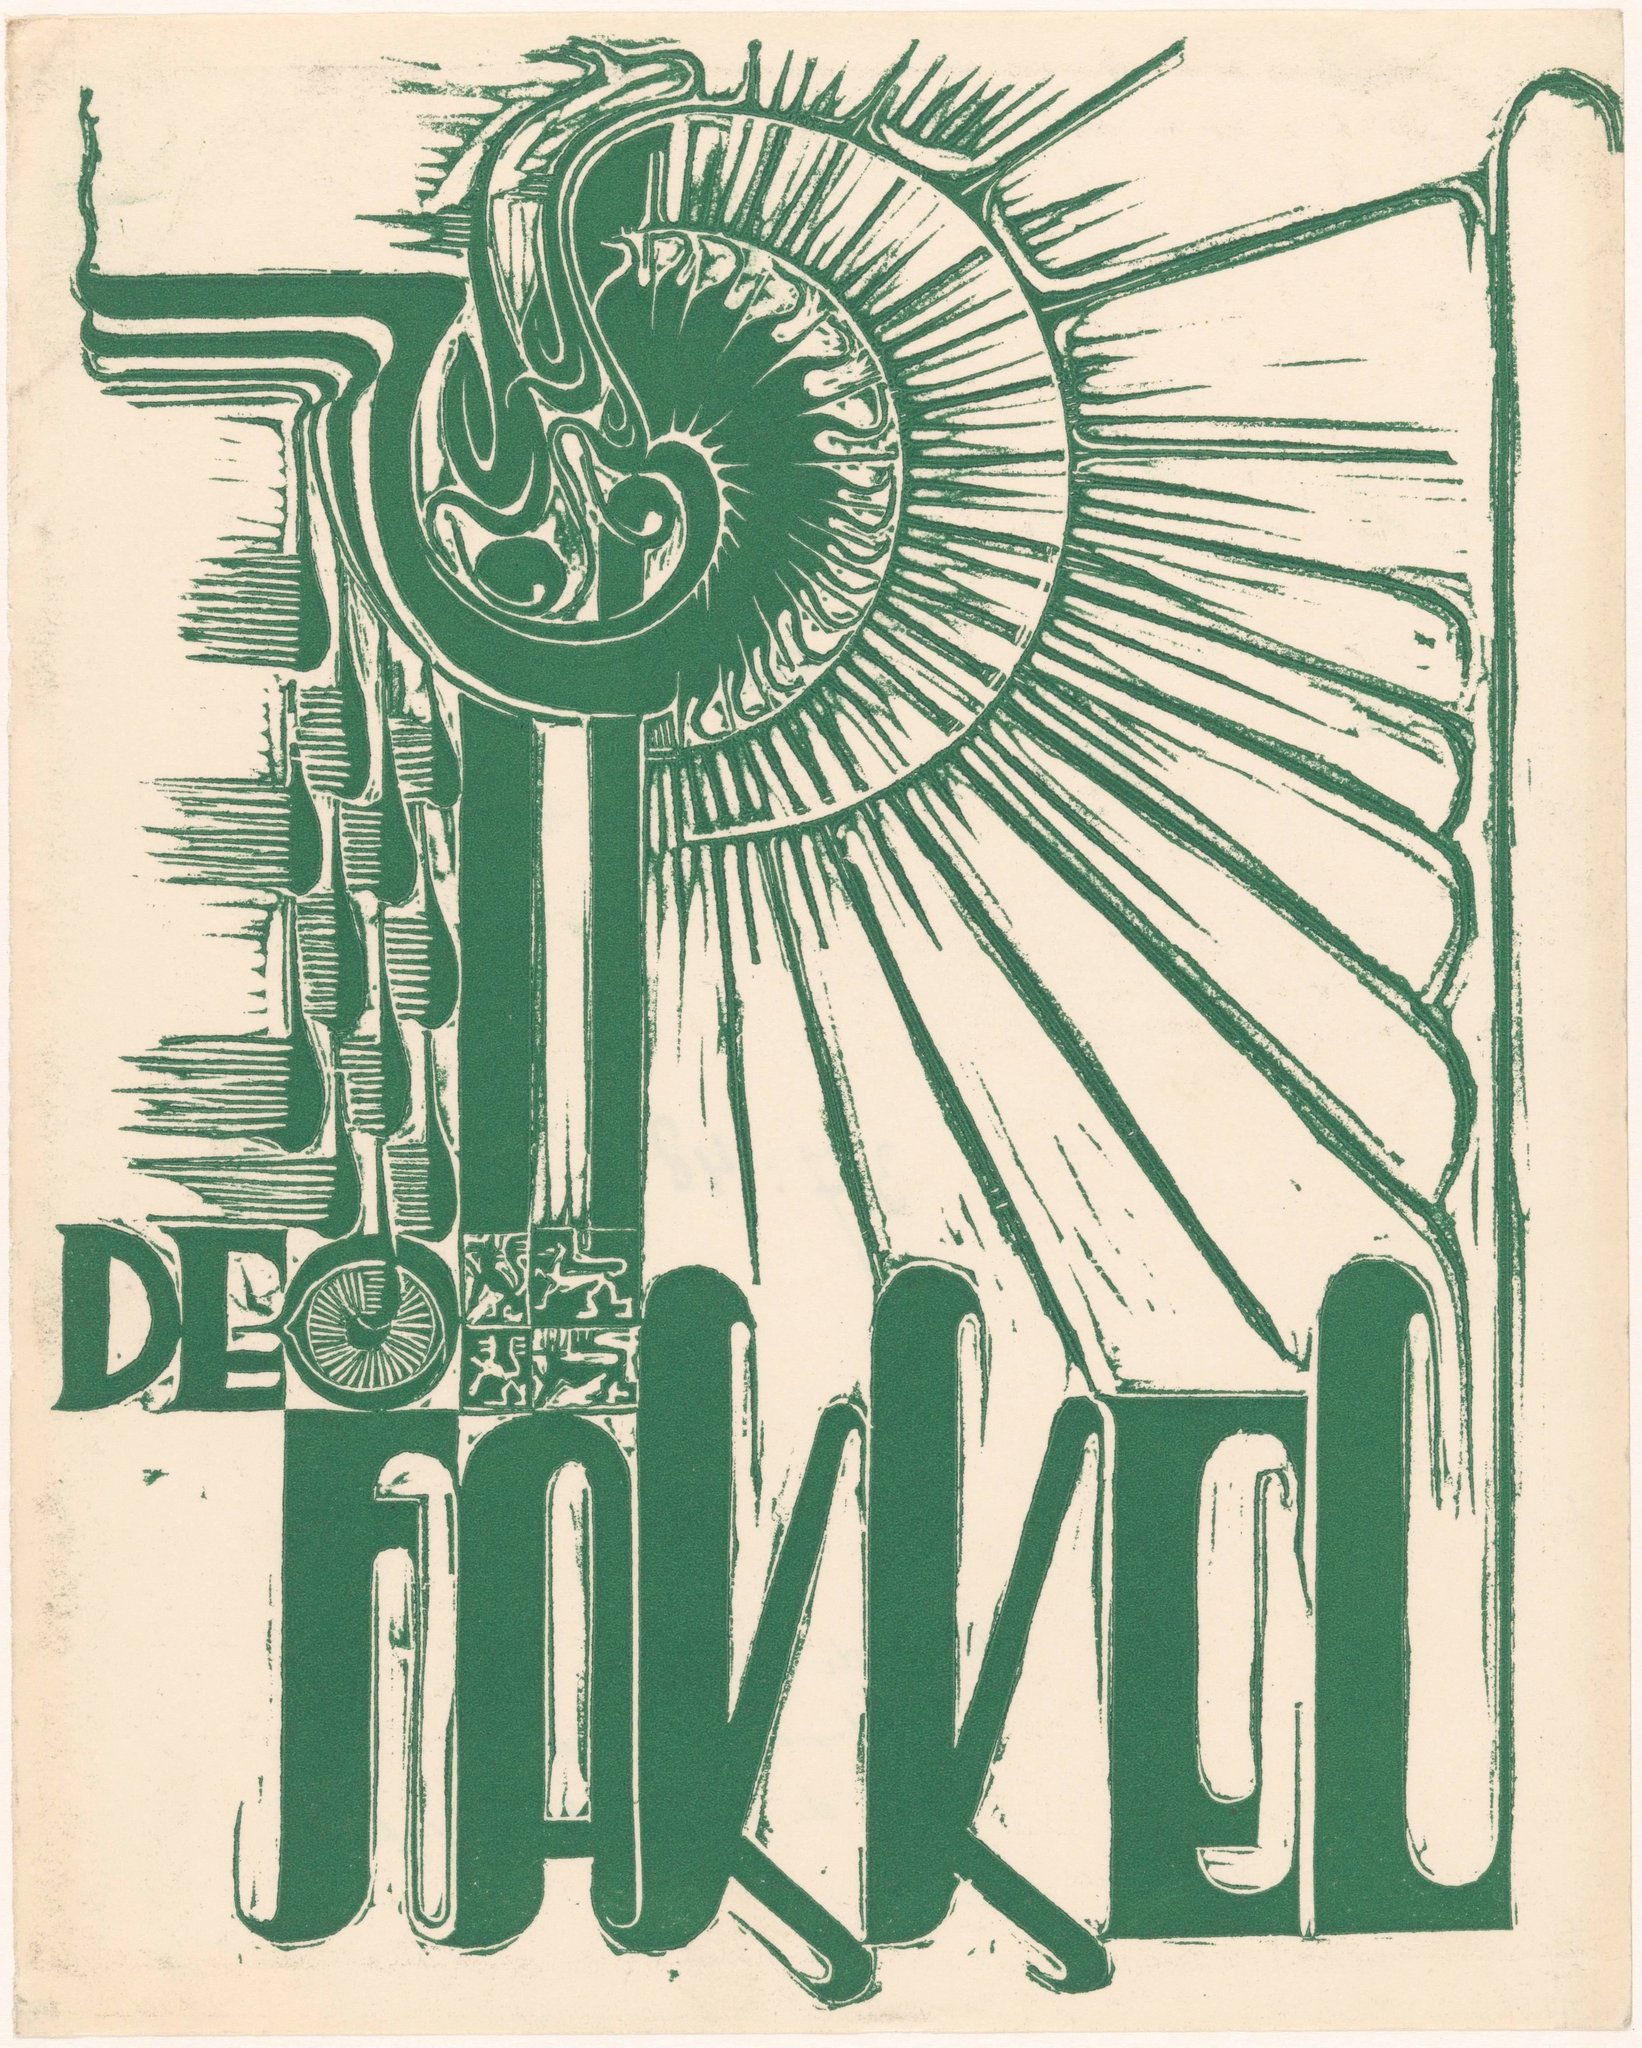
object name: print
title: De Fakkel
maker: a. de bruin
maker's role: print maker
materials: paper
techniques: linocut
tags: ornaments ~ art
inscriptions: collector's mark: Lugt 2760, collector's mark: Lugt 2228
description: Prent gebruikt voor 'De Fakkel', het tijdschrift van de Academie van Beeldende Kunsten en Technische Wetenschappen in Rotterdam.